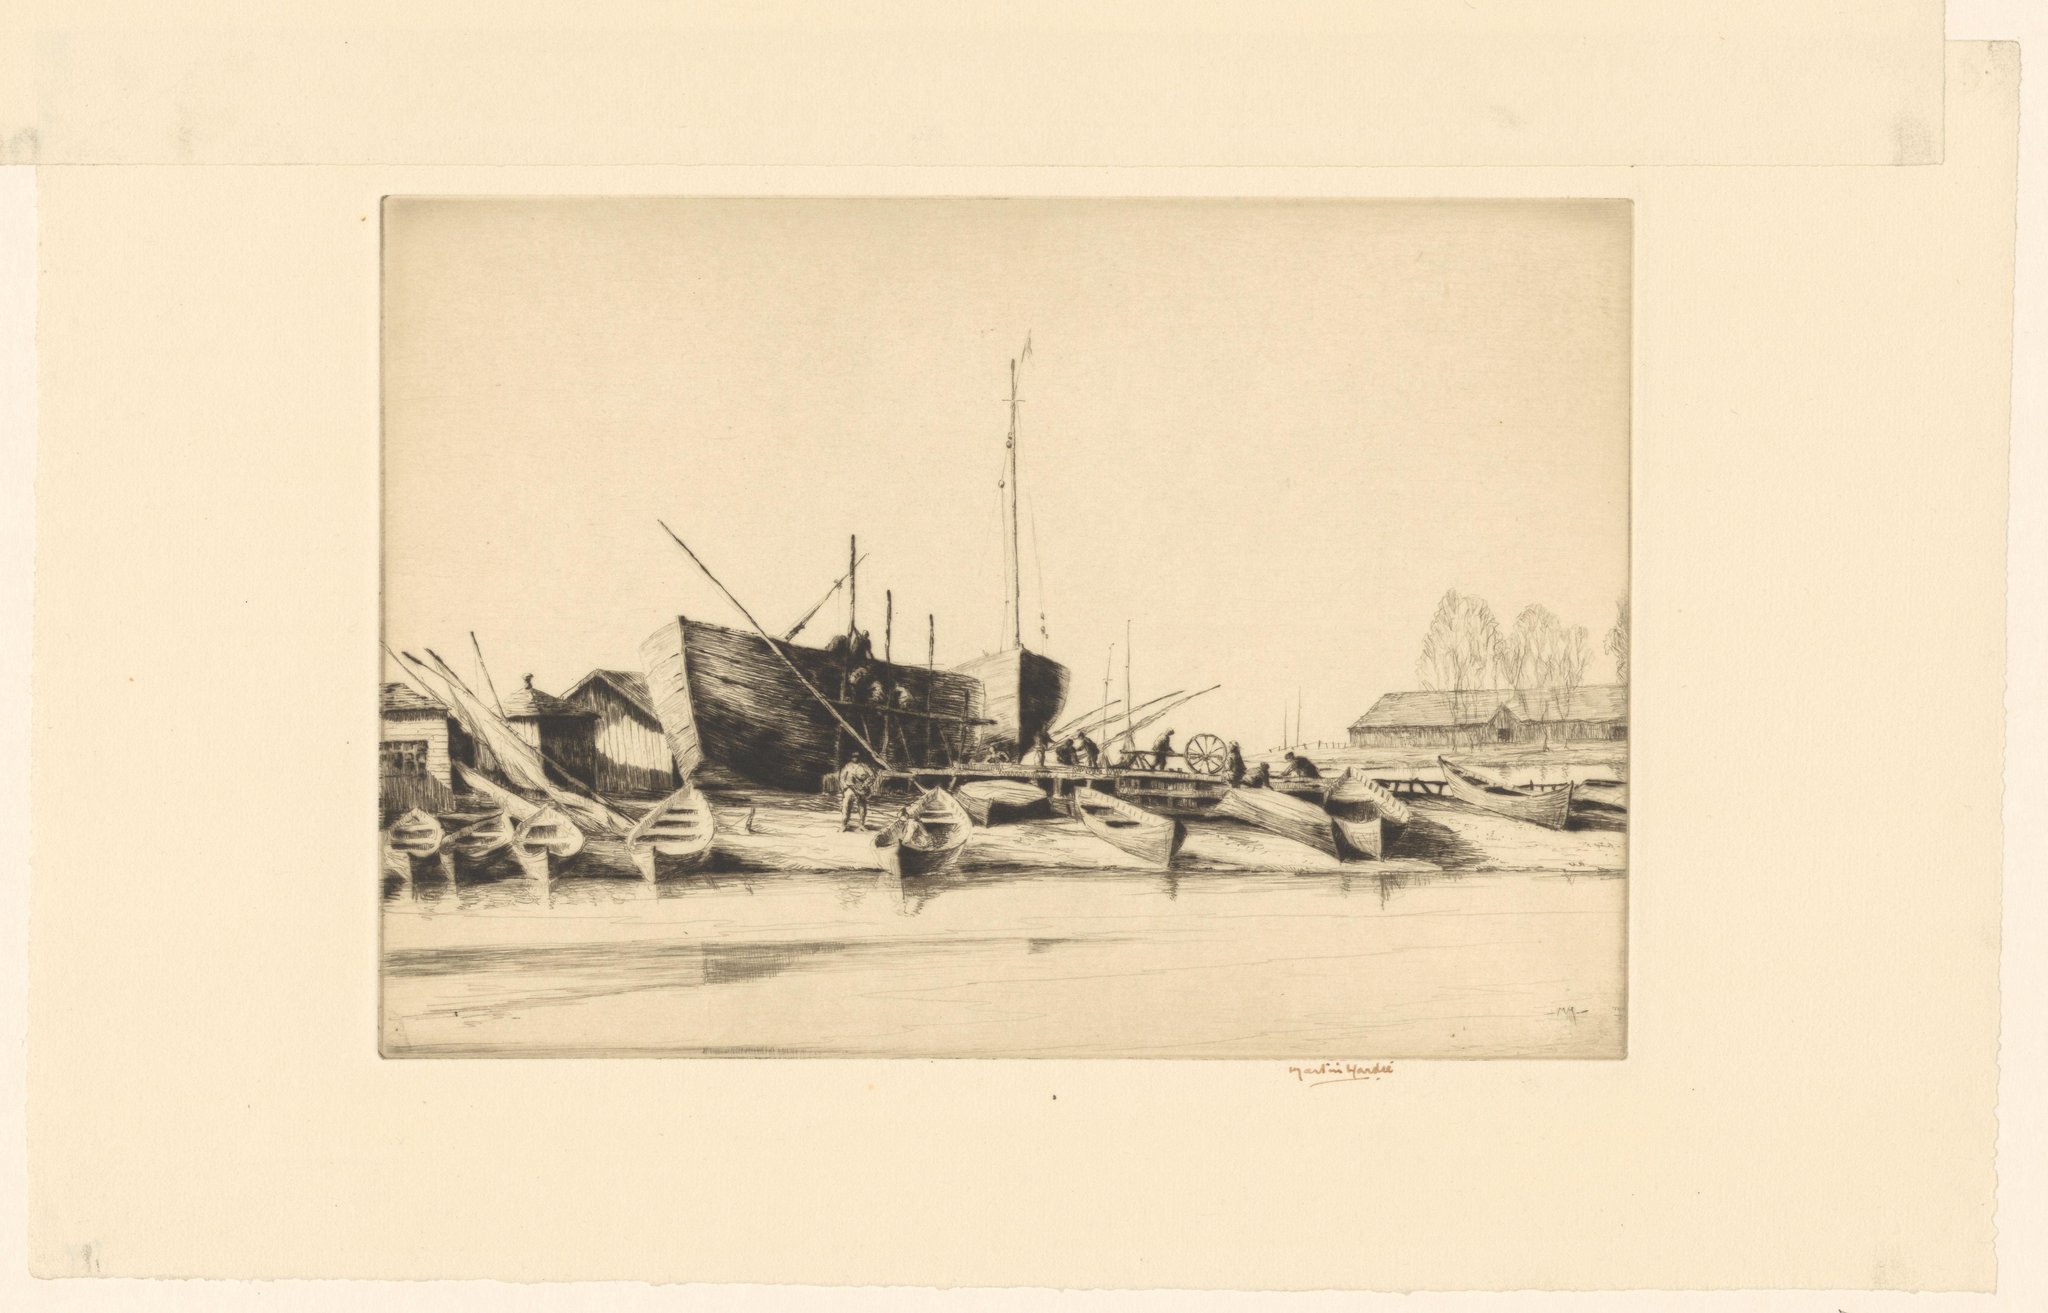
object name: print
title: A Boatyard in Southern France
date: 1924-1929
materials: paper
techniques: drypoint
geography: sete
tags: pier, quay, wharf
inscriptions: annotation: ‘Martin Hardie’, collector's mark: Lugt 2760, collector's mark: Lugt 2228